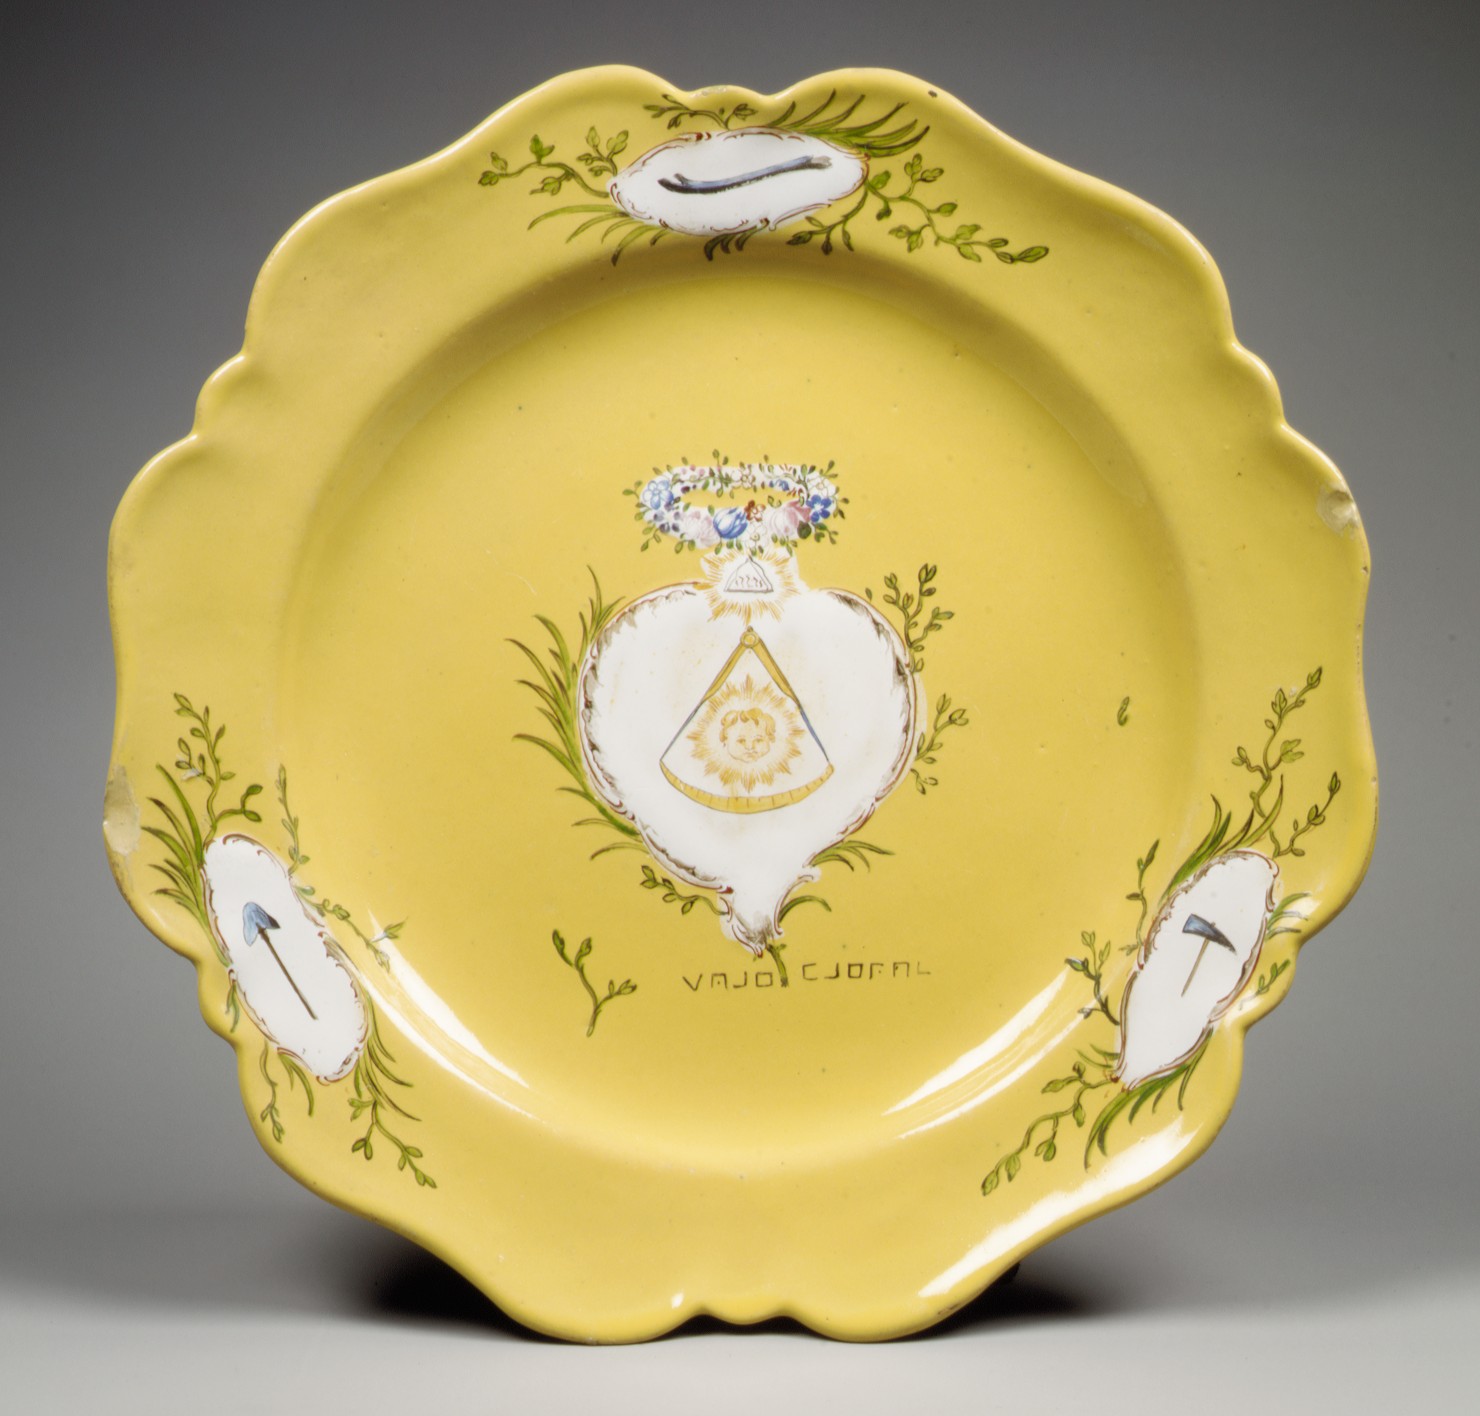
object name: plate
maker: veuve perrin factory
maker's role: factory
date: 1760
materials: faience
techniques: glazing